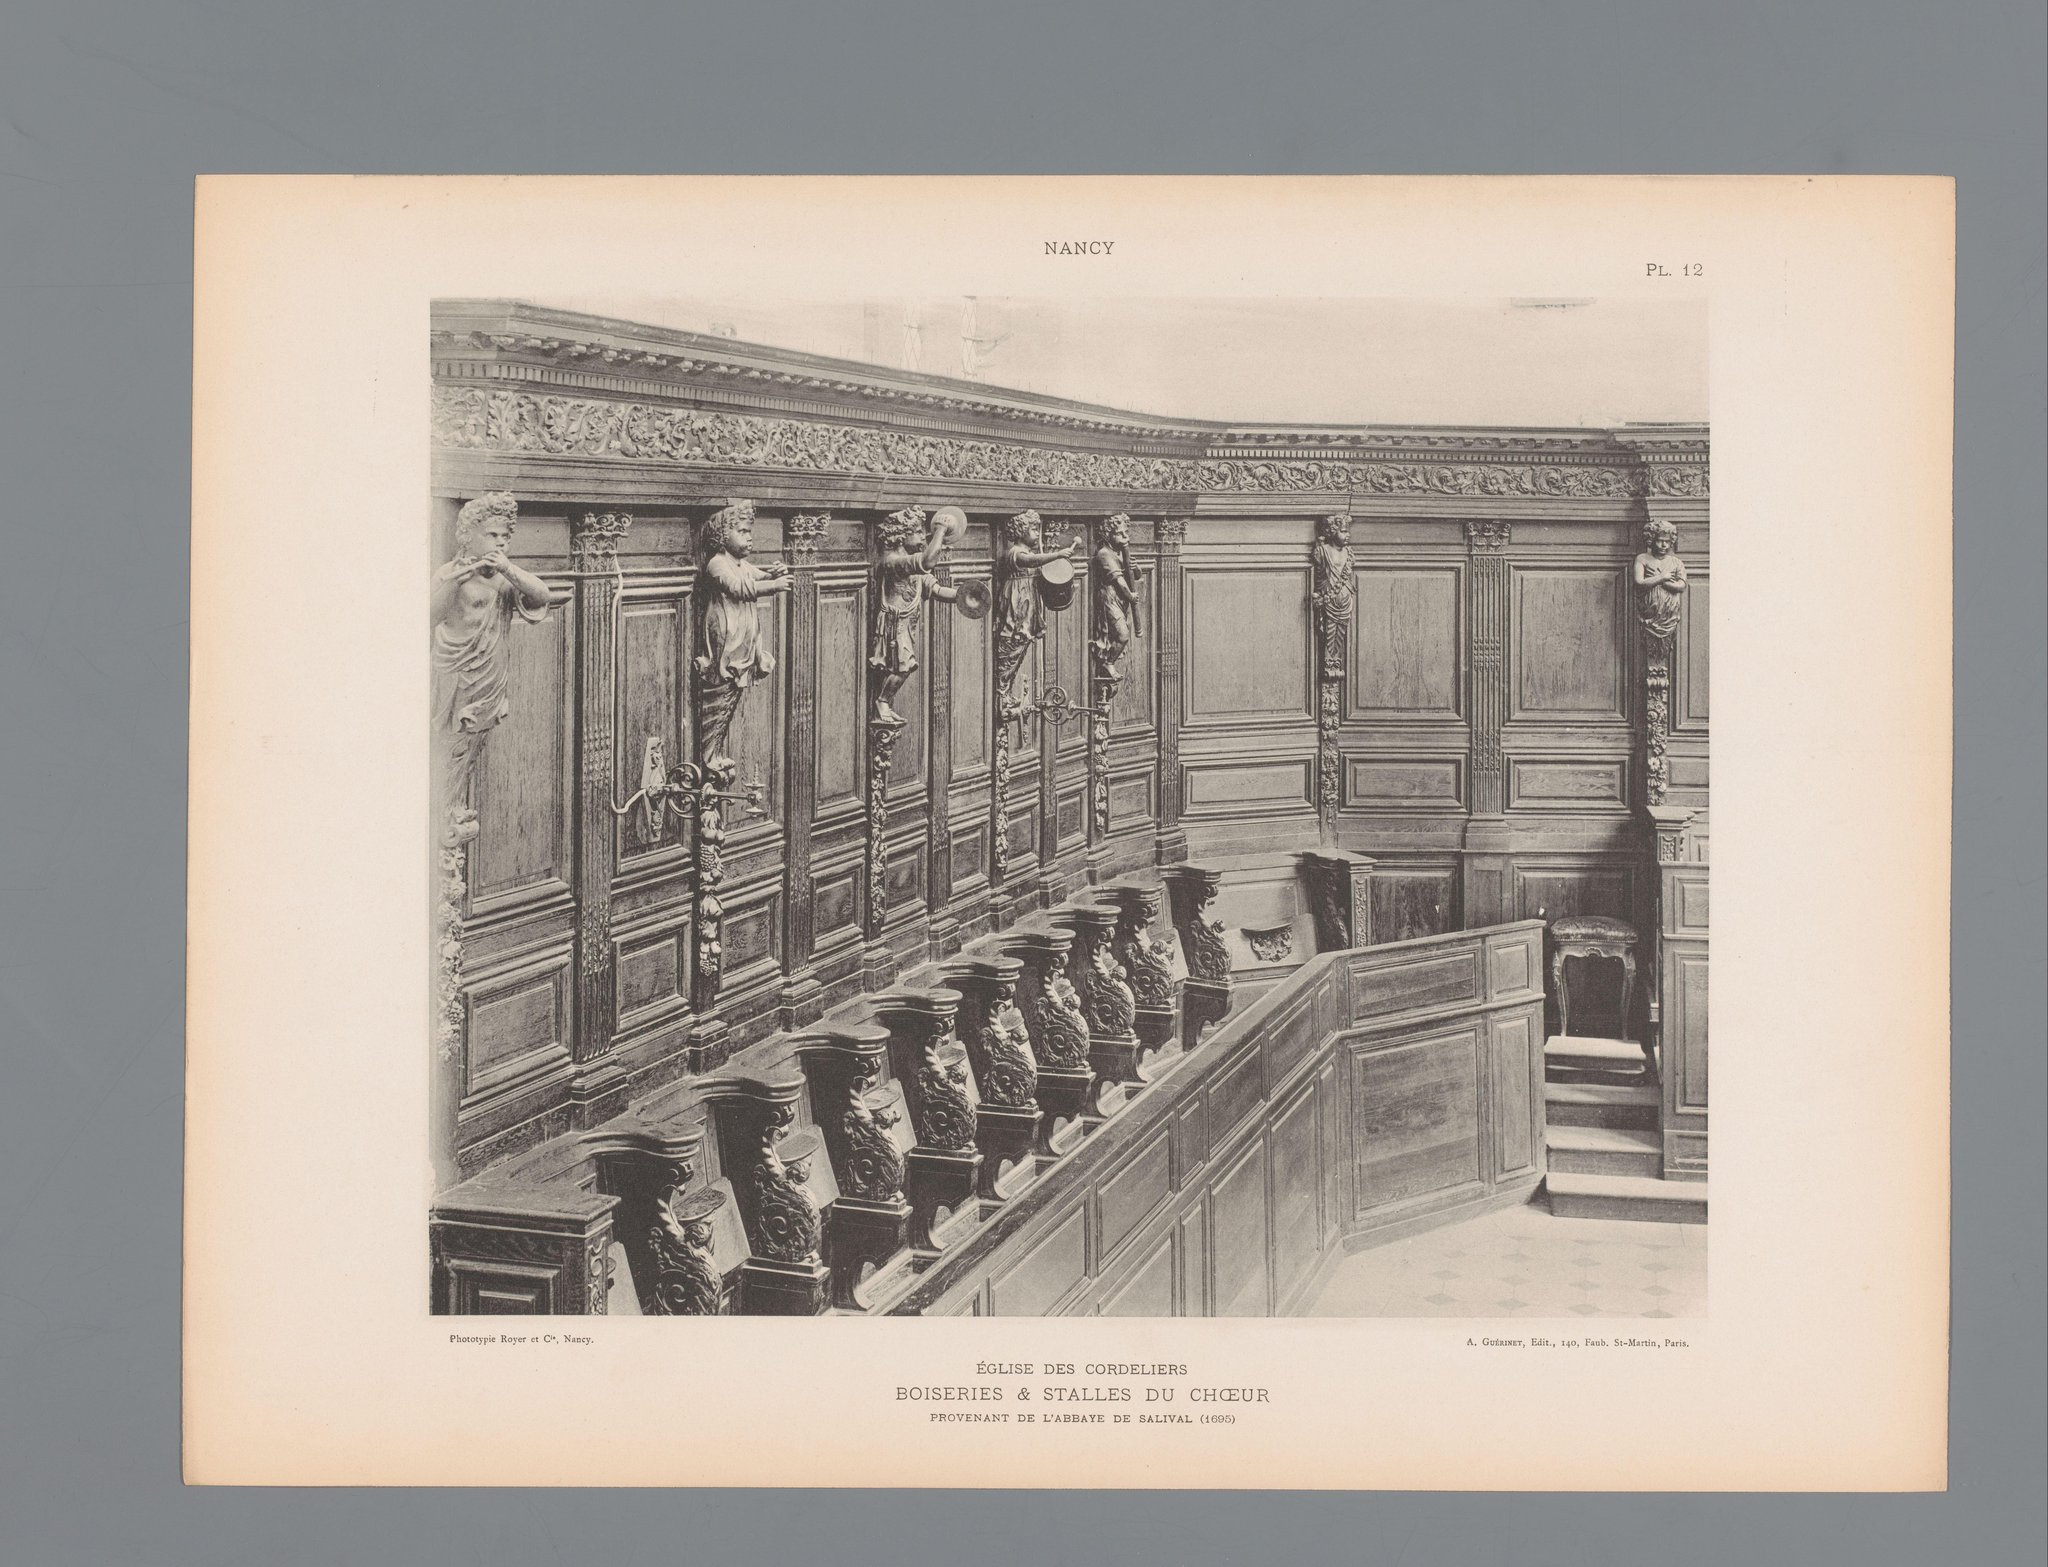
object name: photomechanical print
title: Koorbanken in de Église des Cordeliers te Nancy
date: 1891-1896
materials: paper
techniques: photograph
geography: nancy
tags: parts of church interior: choir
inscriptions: inscription: ‘Boiseries & stalles du choeur (...)’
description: Deze prent maakt deel uit van een omslag met 103 prenten op 101 bladen en een titelblad.